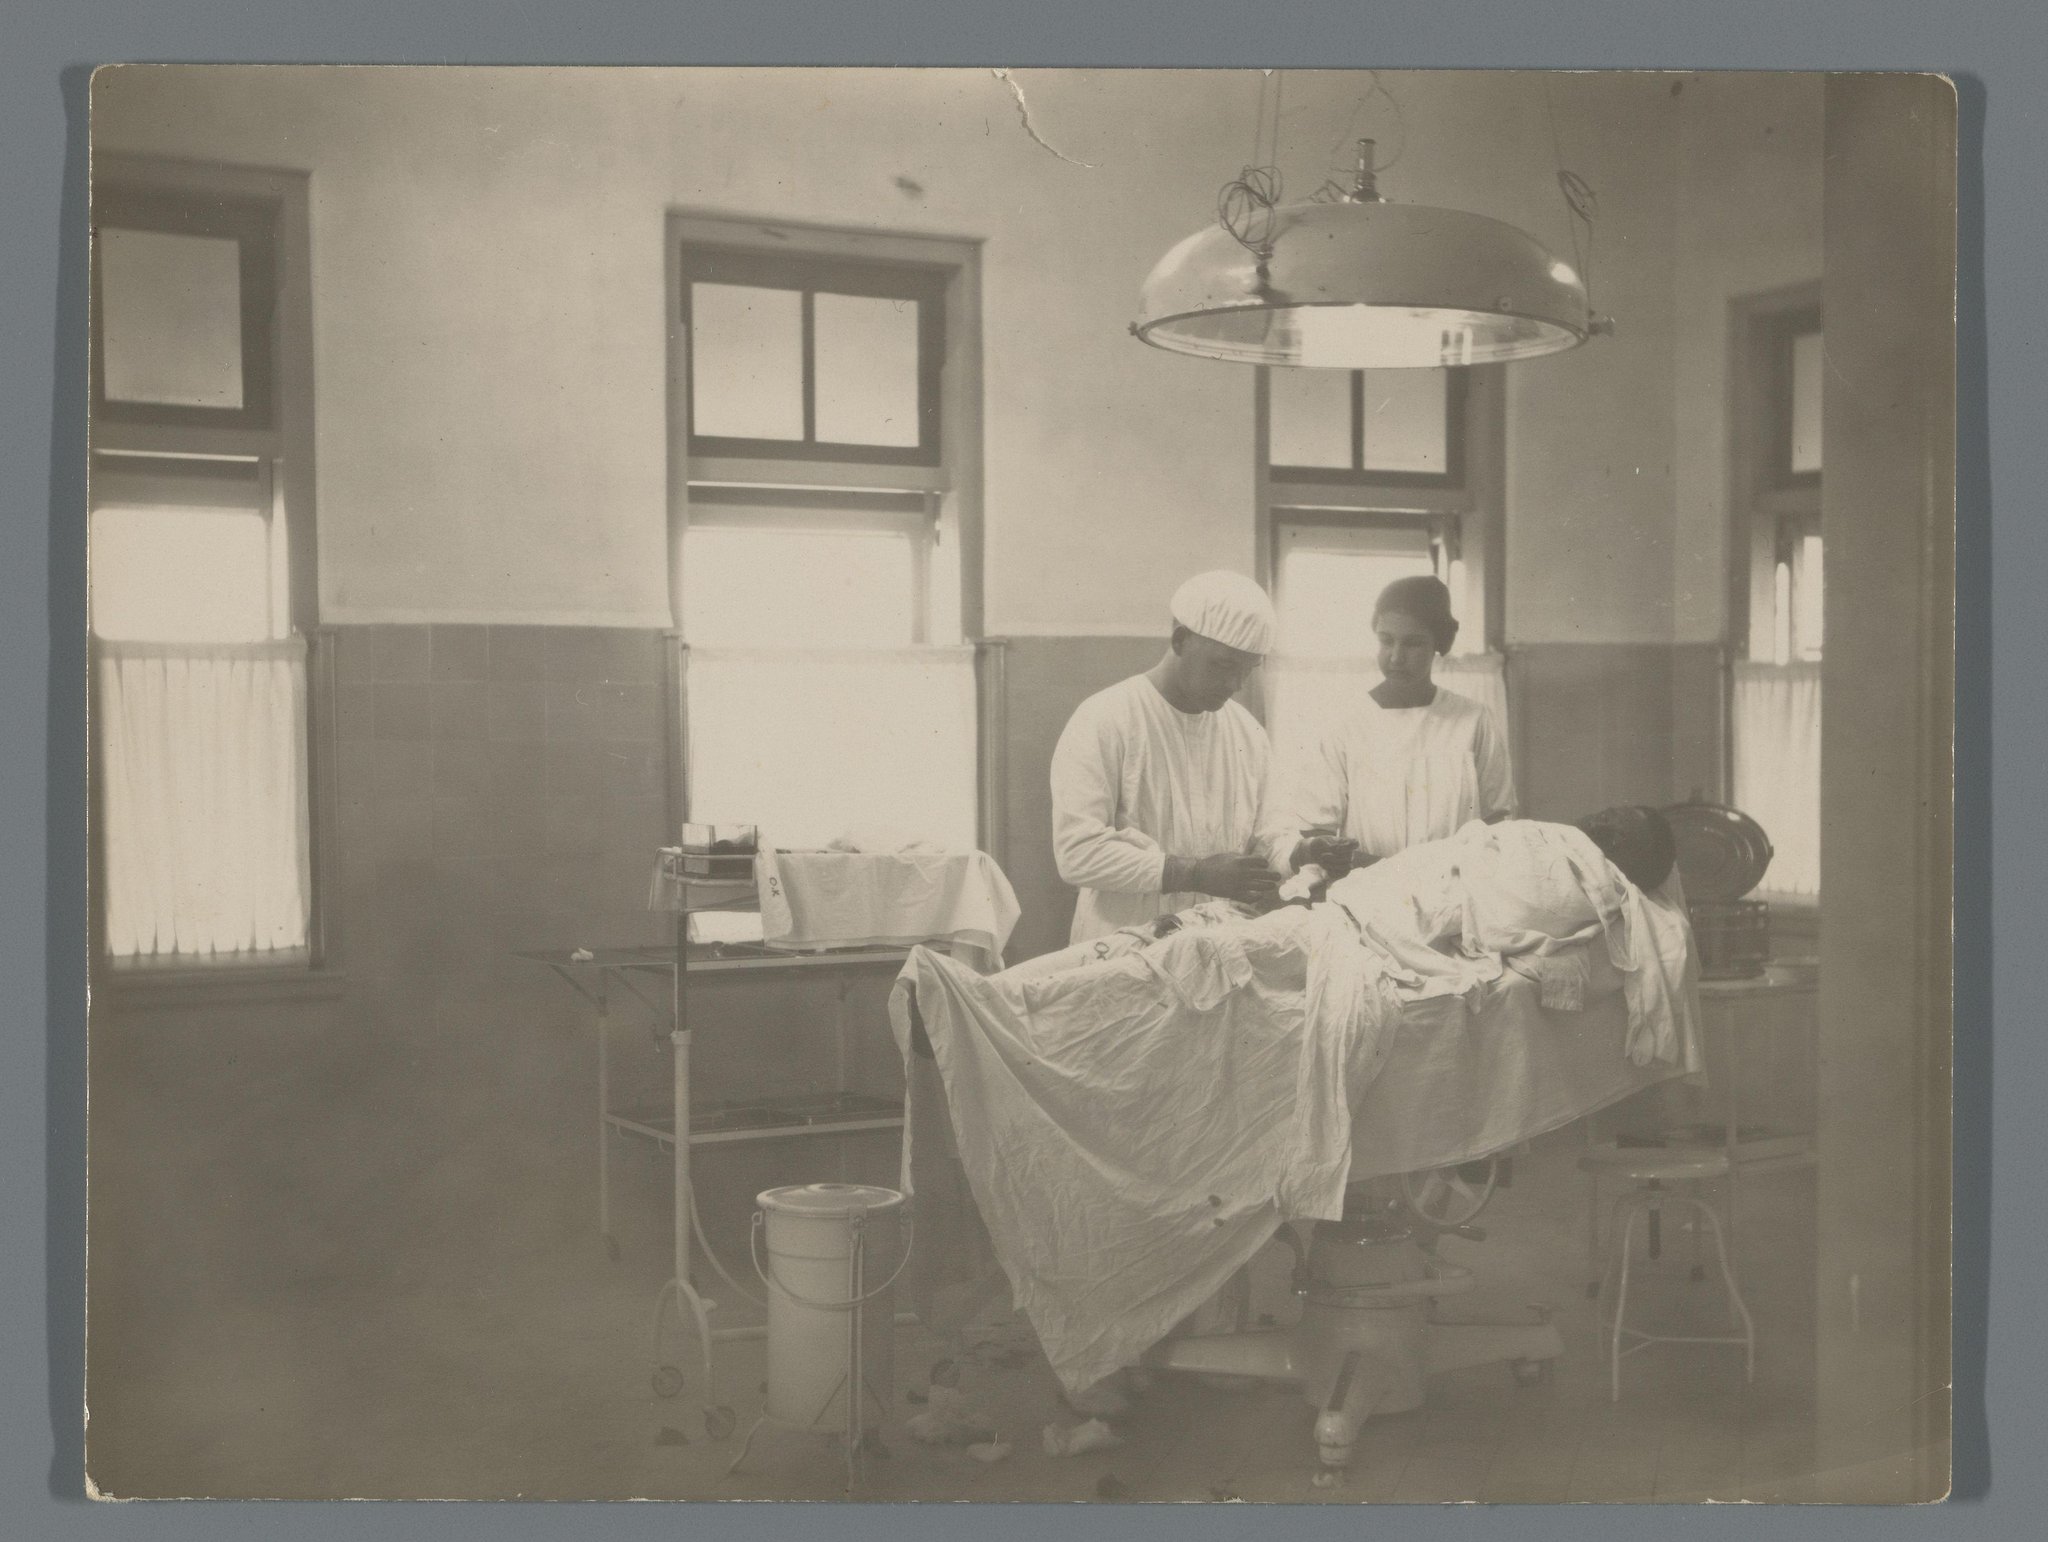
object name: photograph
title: Operatie in een Surinaams ziekenhuis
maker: Anonymous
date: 1925-1927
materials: photographic support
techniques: photography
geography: suriname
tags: jetten, familie, moengo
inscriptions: inscription: ‘Calle aan het opereren’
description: Operatie in een Surinaams ziekenhuis door een Nederlandse arts (aangeduid in het opschrift als: Calle), bijgestaan door een vrouwelijke assistent.